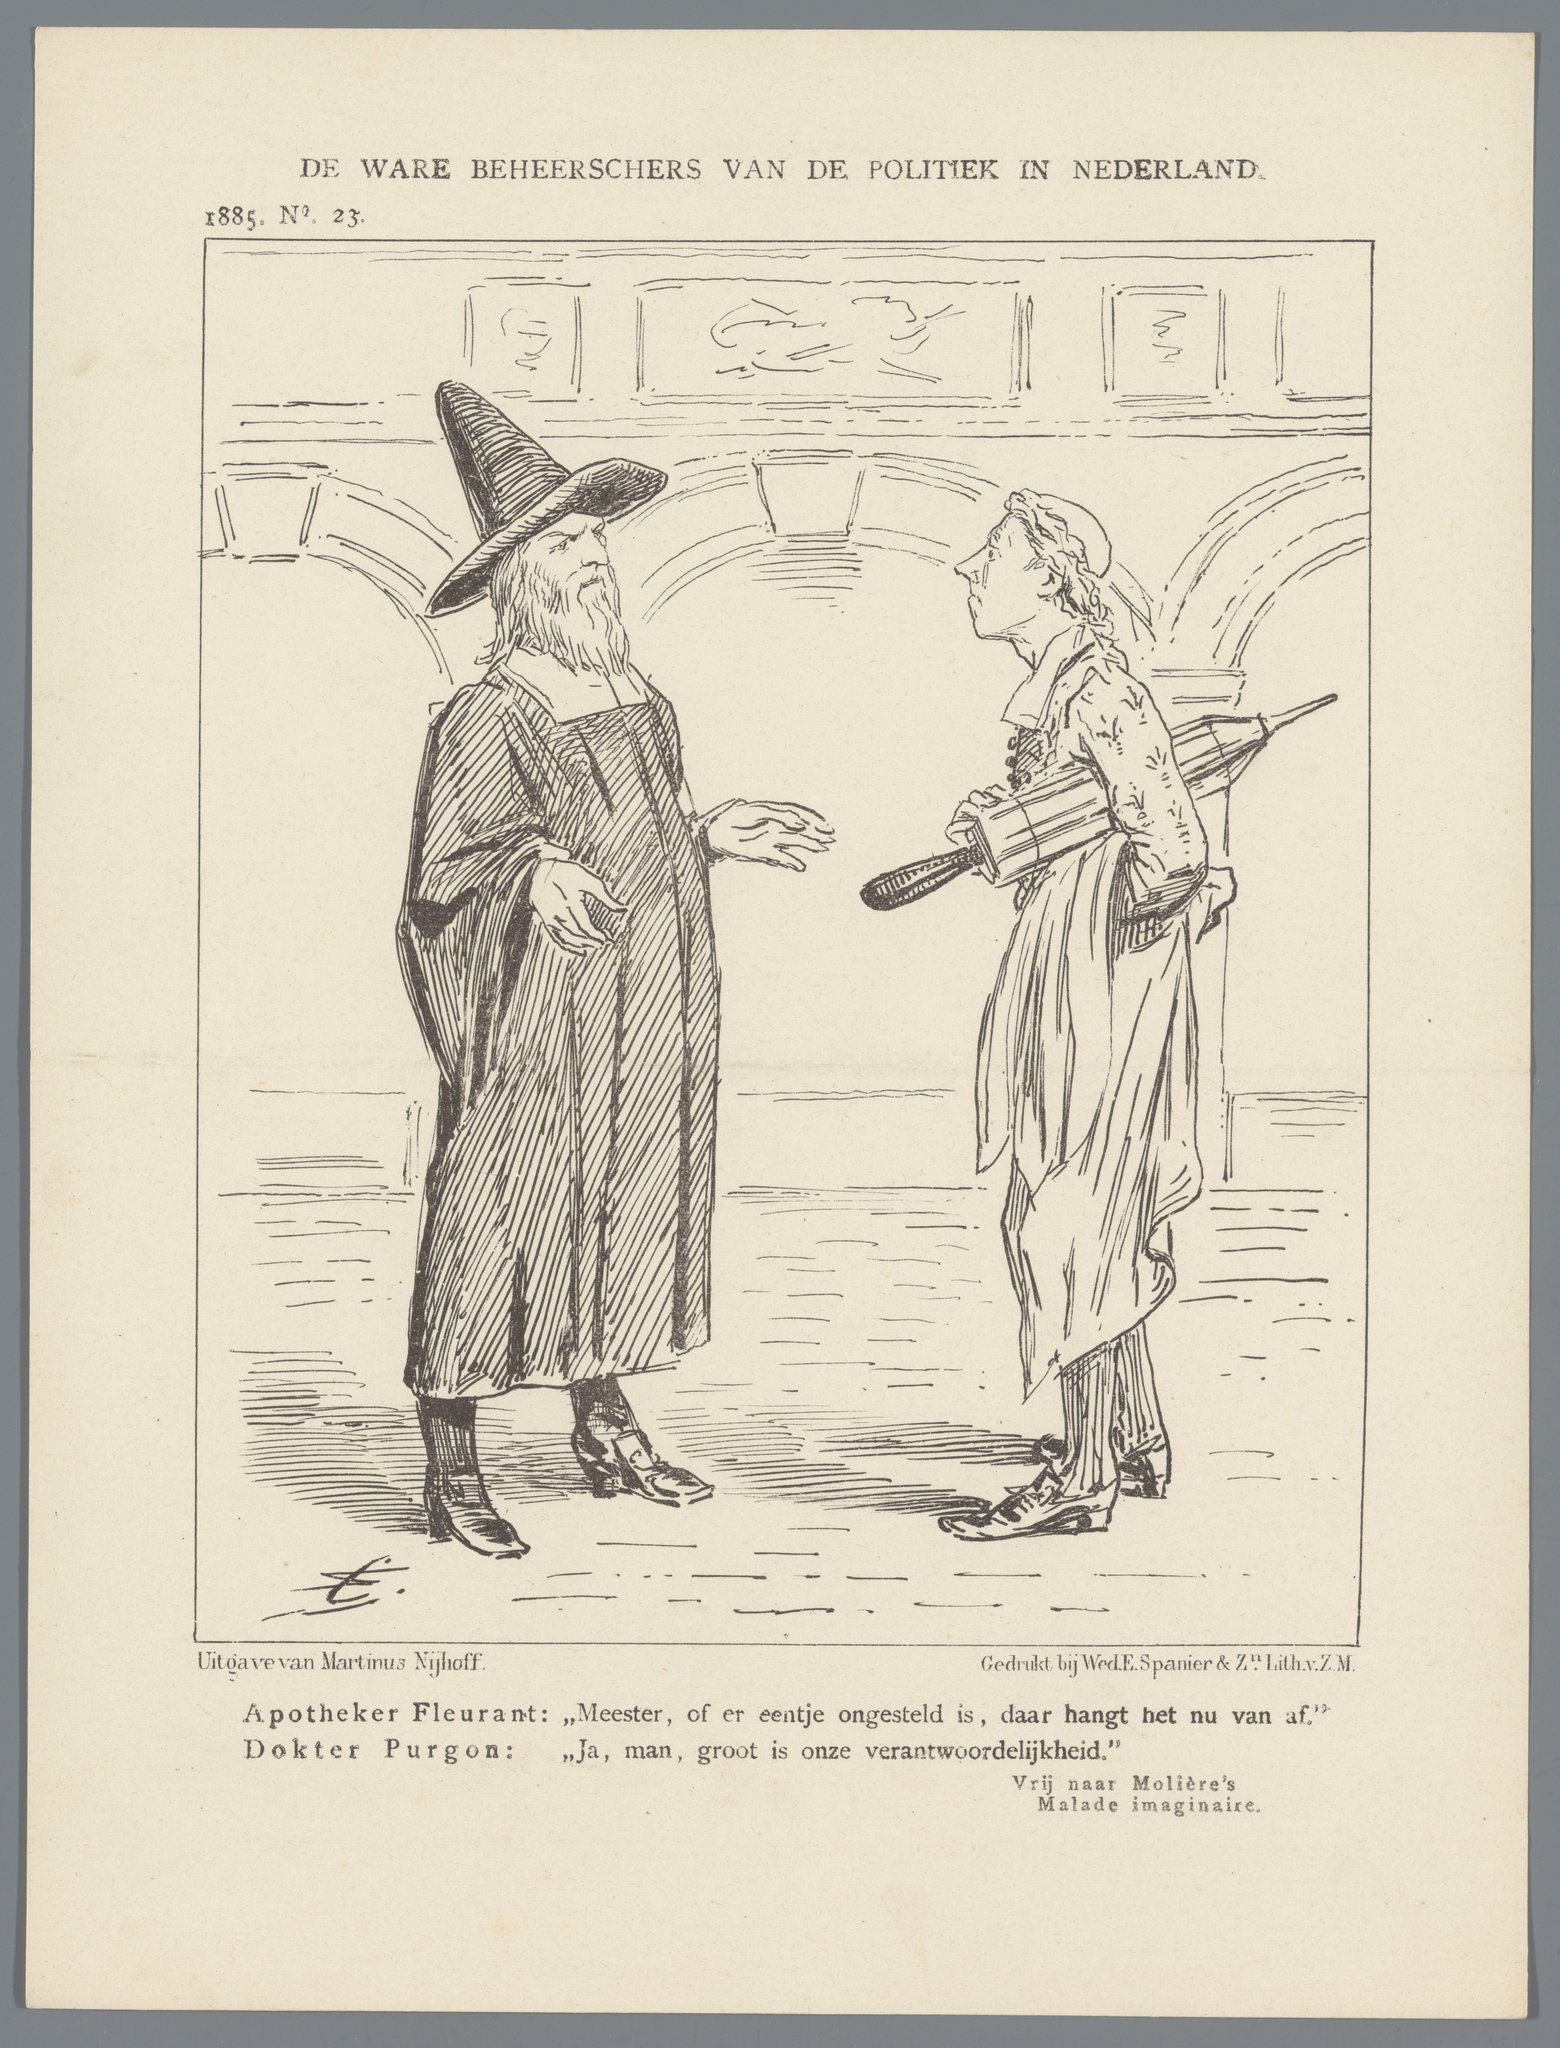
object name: print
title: Spotprent over twee kwakzalvers in de politiek, 1885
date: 1885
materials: paper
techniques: lithograph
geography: netherlands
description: Spotprent over twee kwakzalvers in de Nederlandse politiek. Plaat verschenen bij het weekblad De Nederlandsche Spectator, nr. 23, 1885.